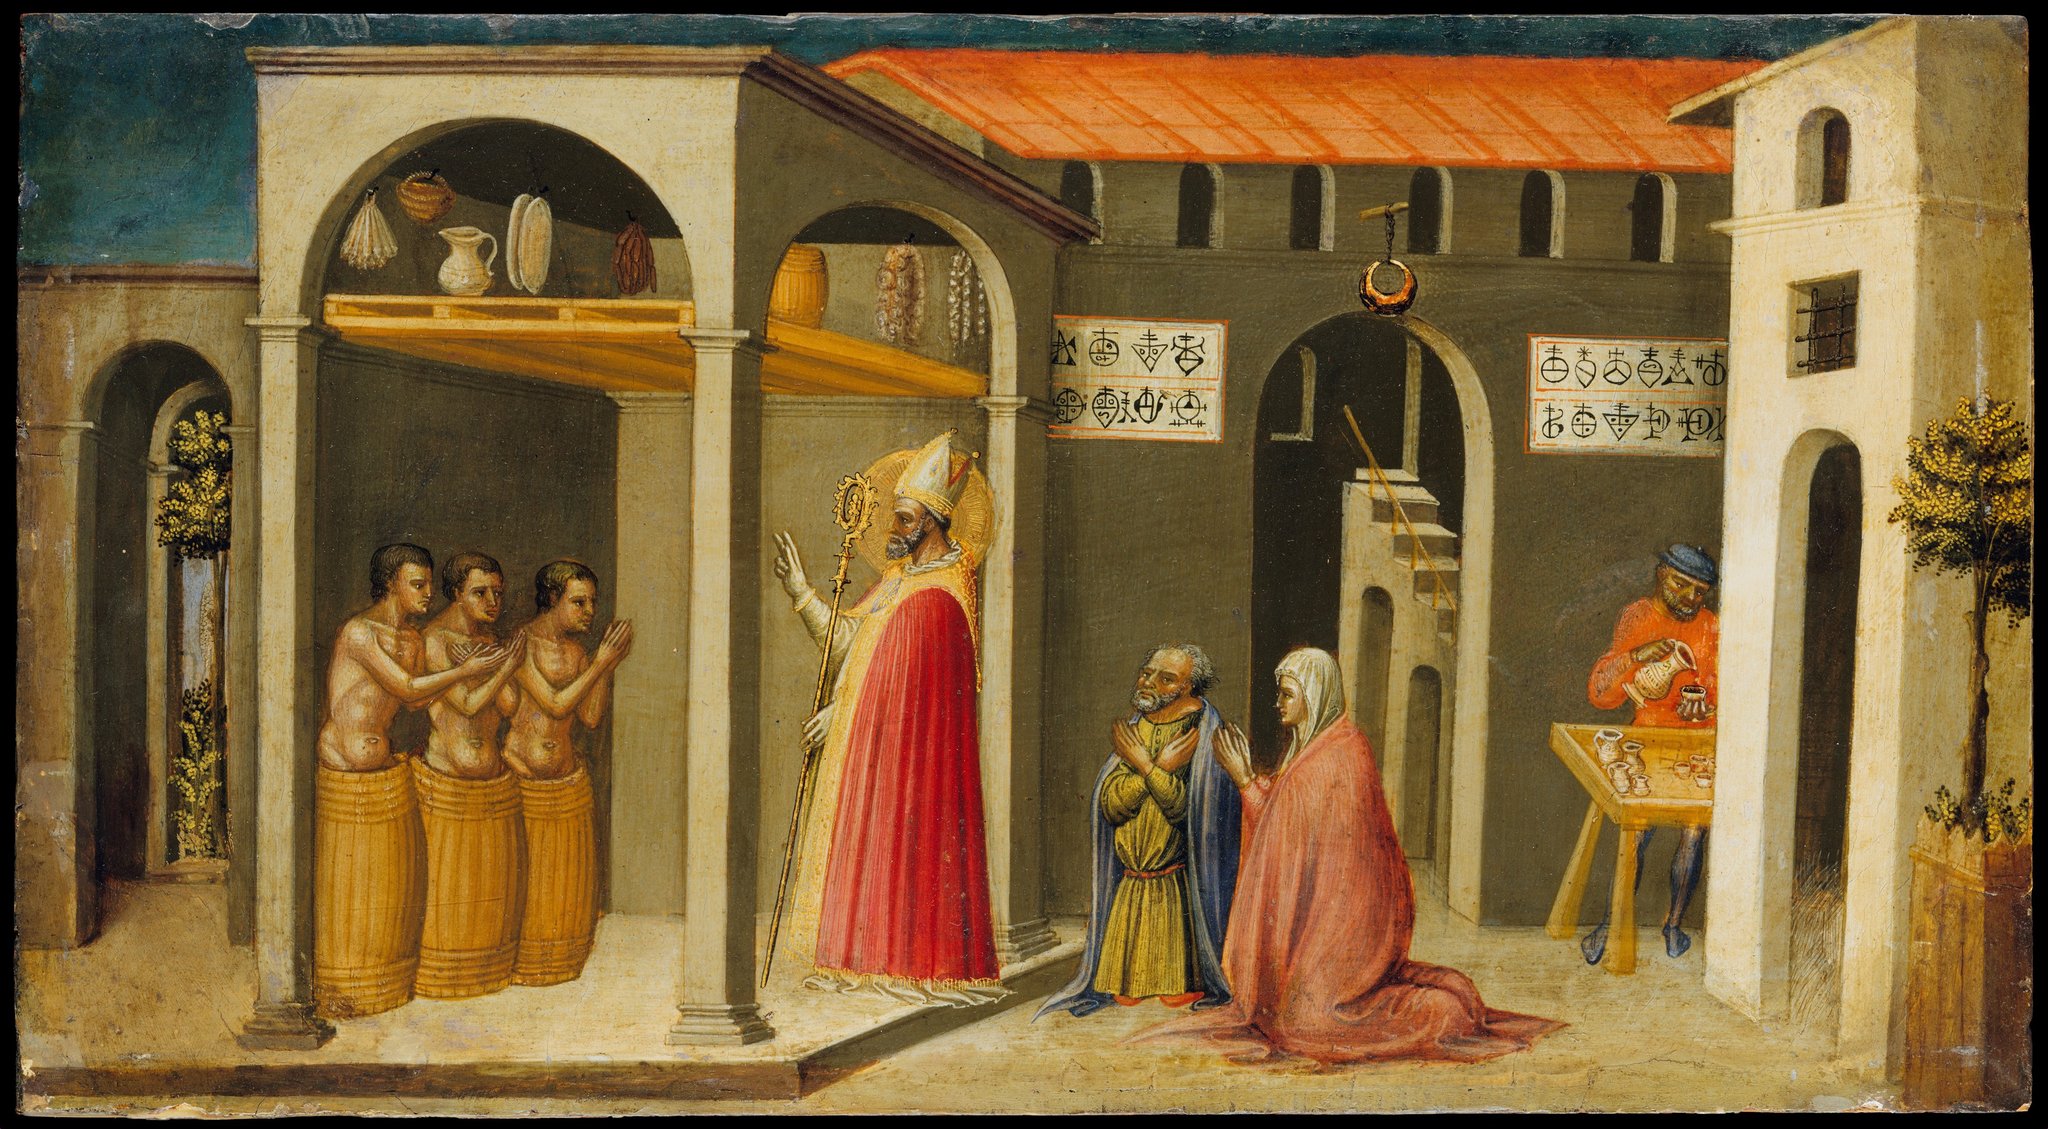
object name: painting, predella panel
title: Saint Nicholas Resuscitating Three Youths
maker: bicci di lorenzo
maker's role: artist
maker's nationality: italian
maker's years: 1373-1452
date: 1433-1435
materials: gold, paint, wood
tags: interiors,men,women,saints